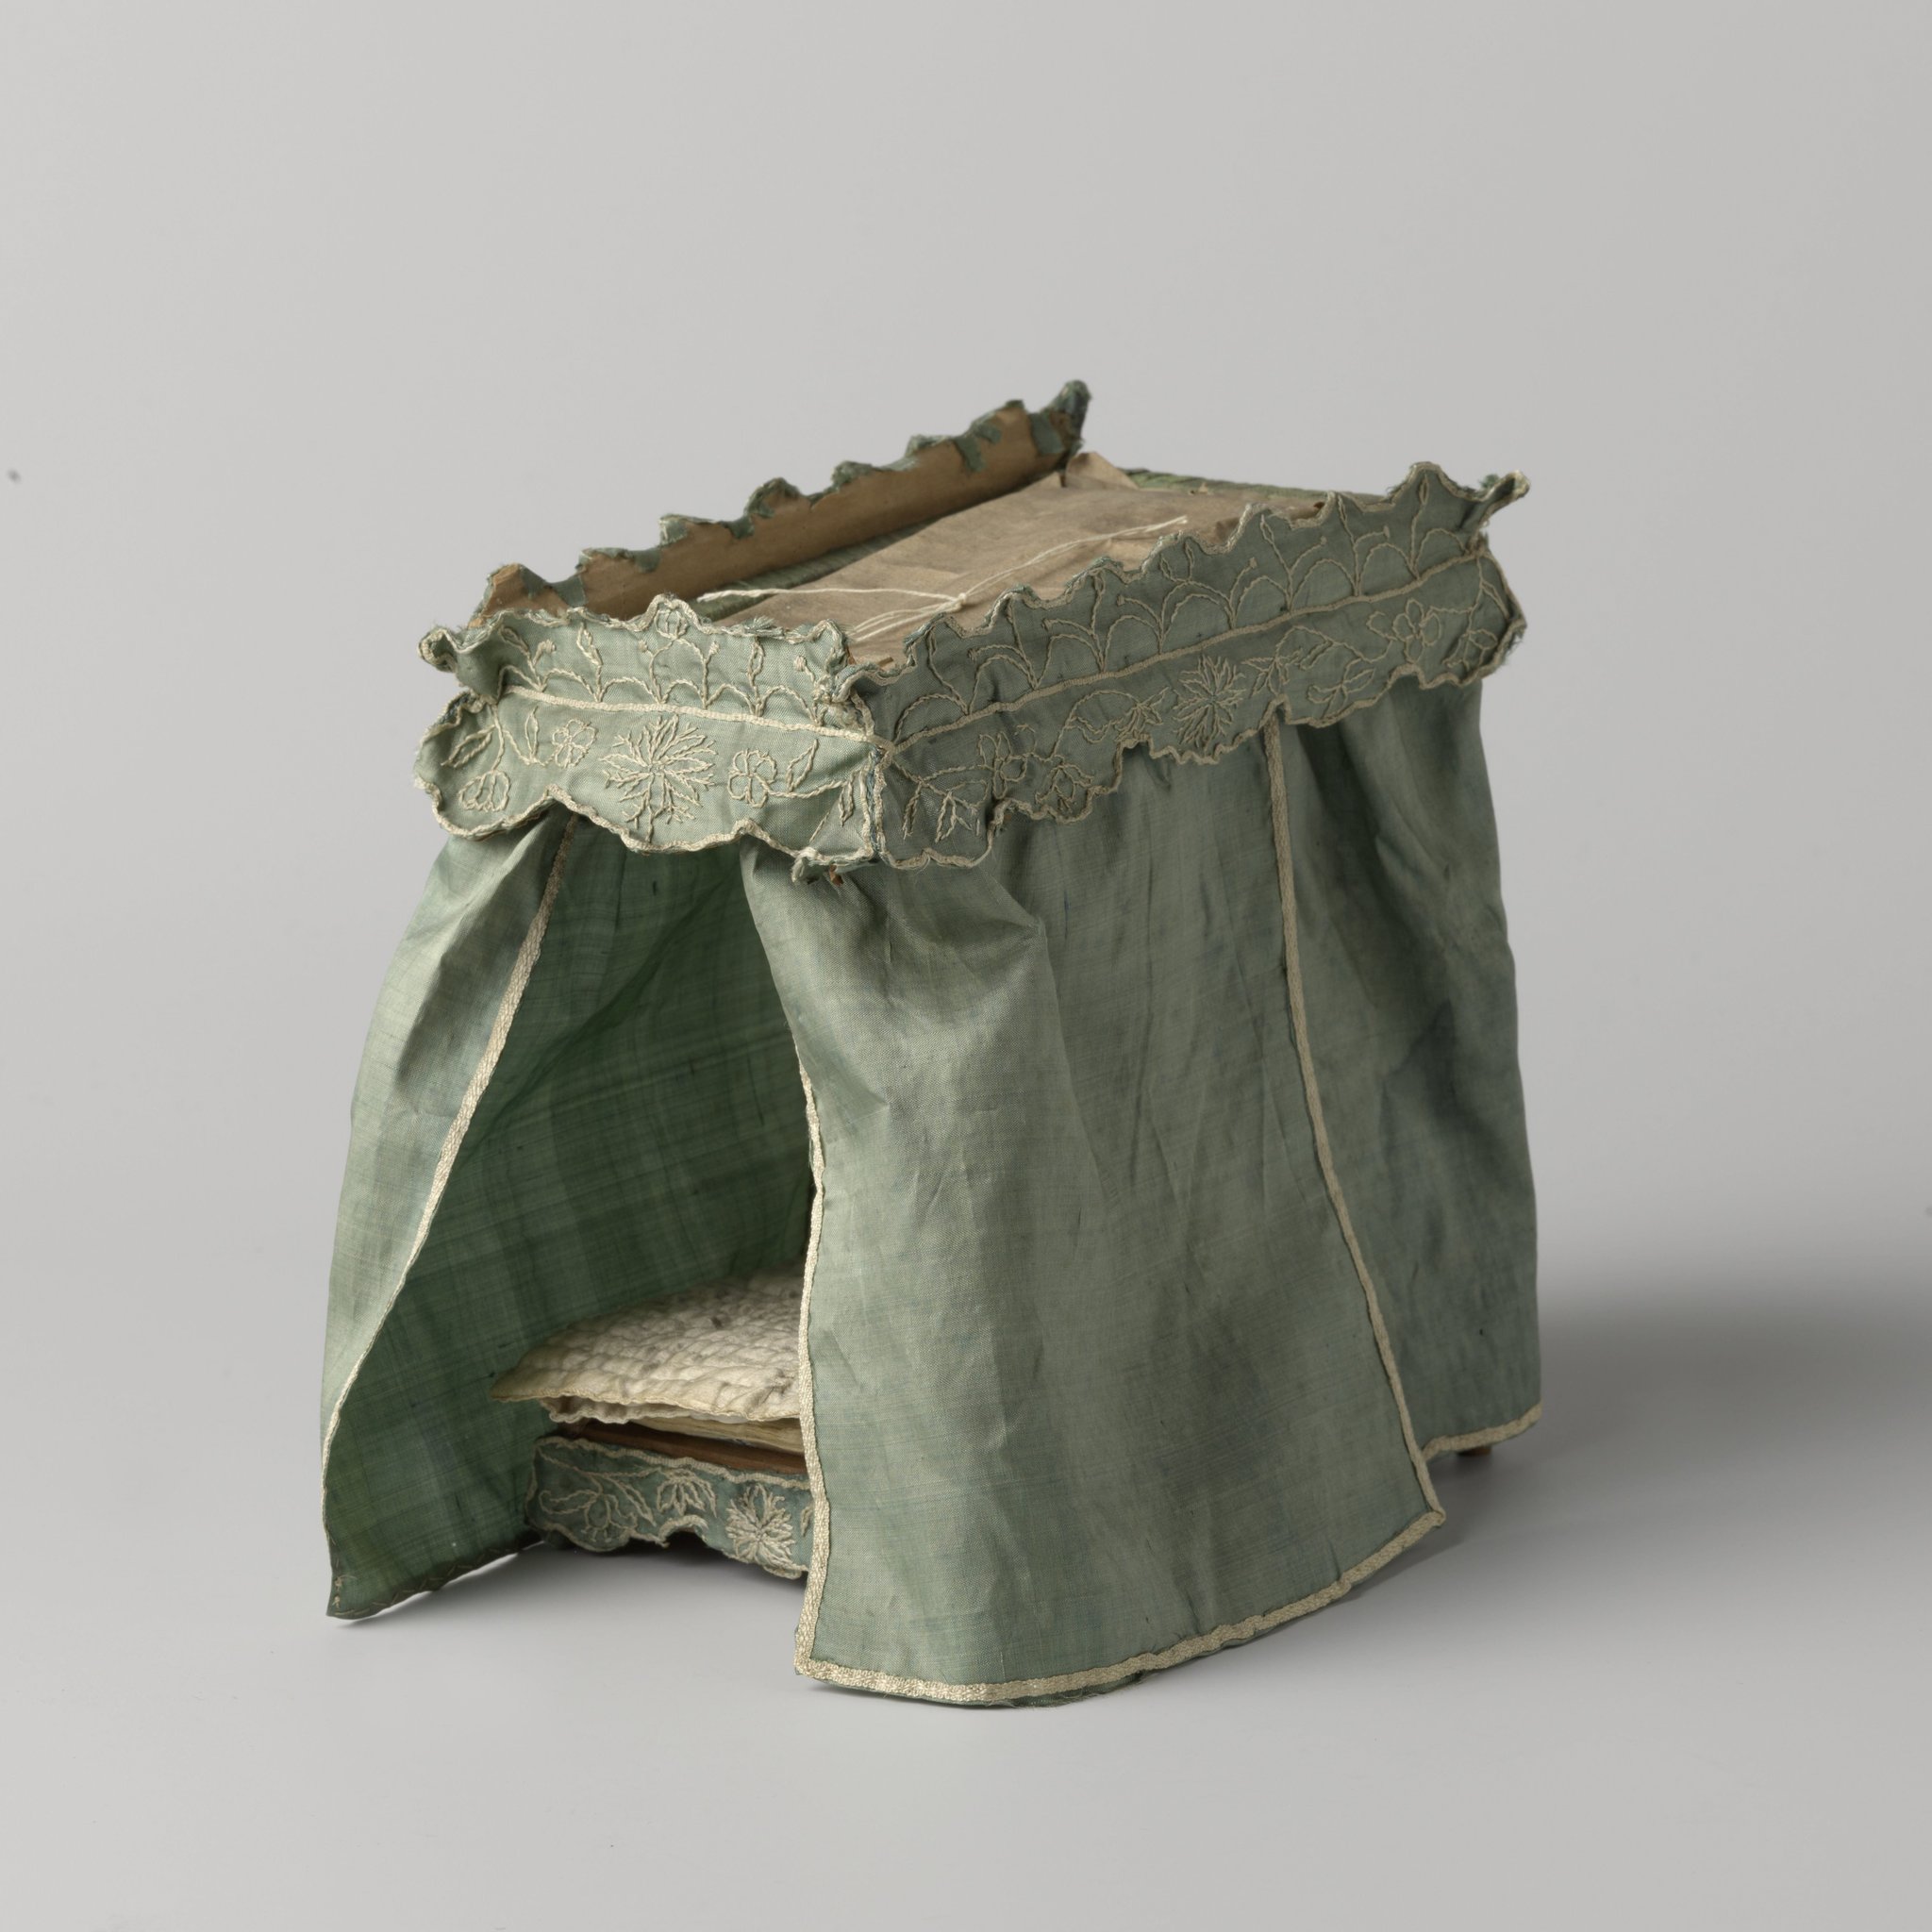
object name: miniature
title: Hemelbed, met blauwgroene gordijnen en vallen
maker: Anonymous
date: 1749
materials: copper, wood, paper, silk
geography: haarlem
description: Hemelbed van het type lit d'Ange van mahoniehout. Het bed is behangen met zacht blauwgroene zijden gordijnen en met vallen, geappliqeerd met wit zijden band en garen.